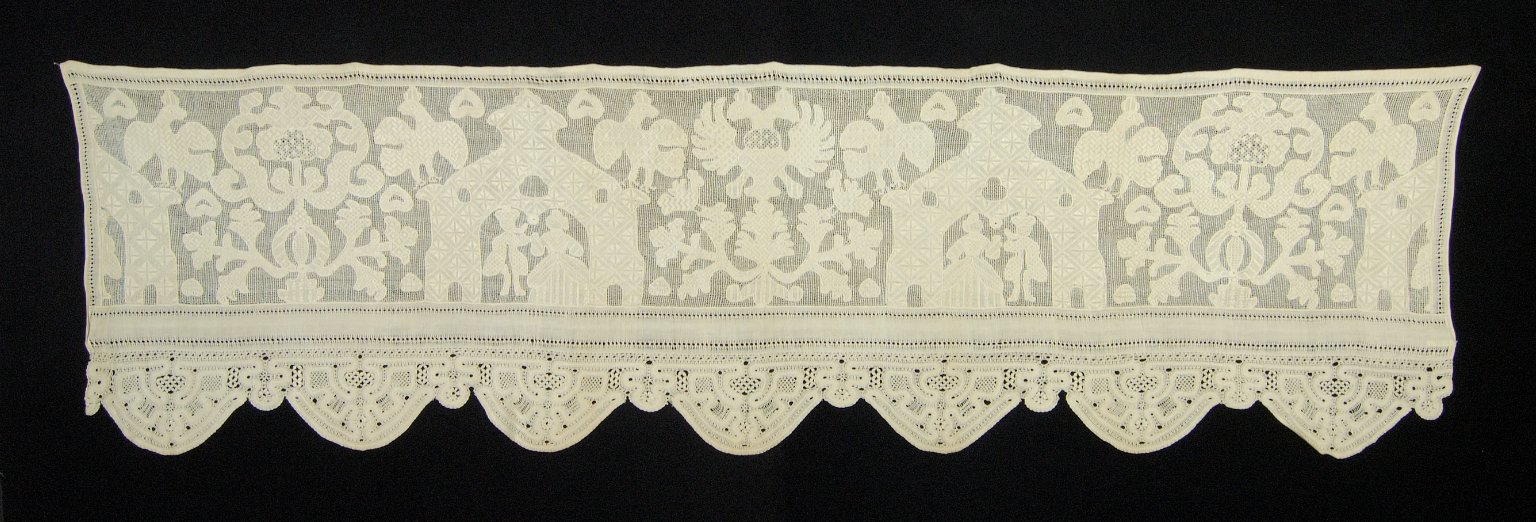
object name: border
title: Bed curtain border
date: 1800-1850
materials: linen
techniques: lace, embroidery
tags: birds